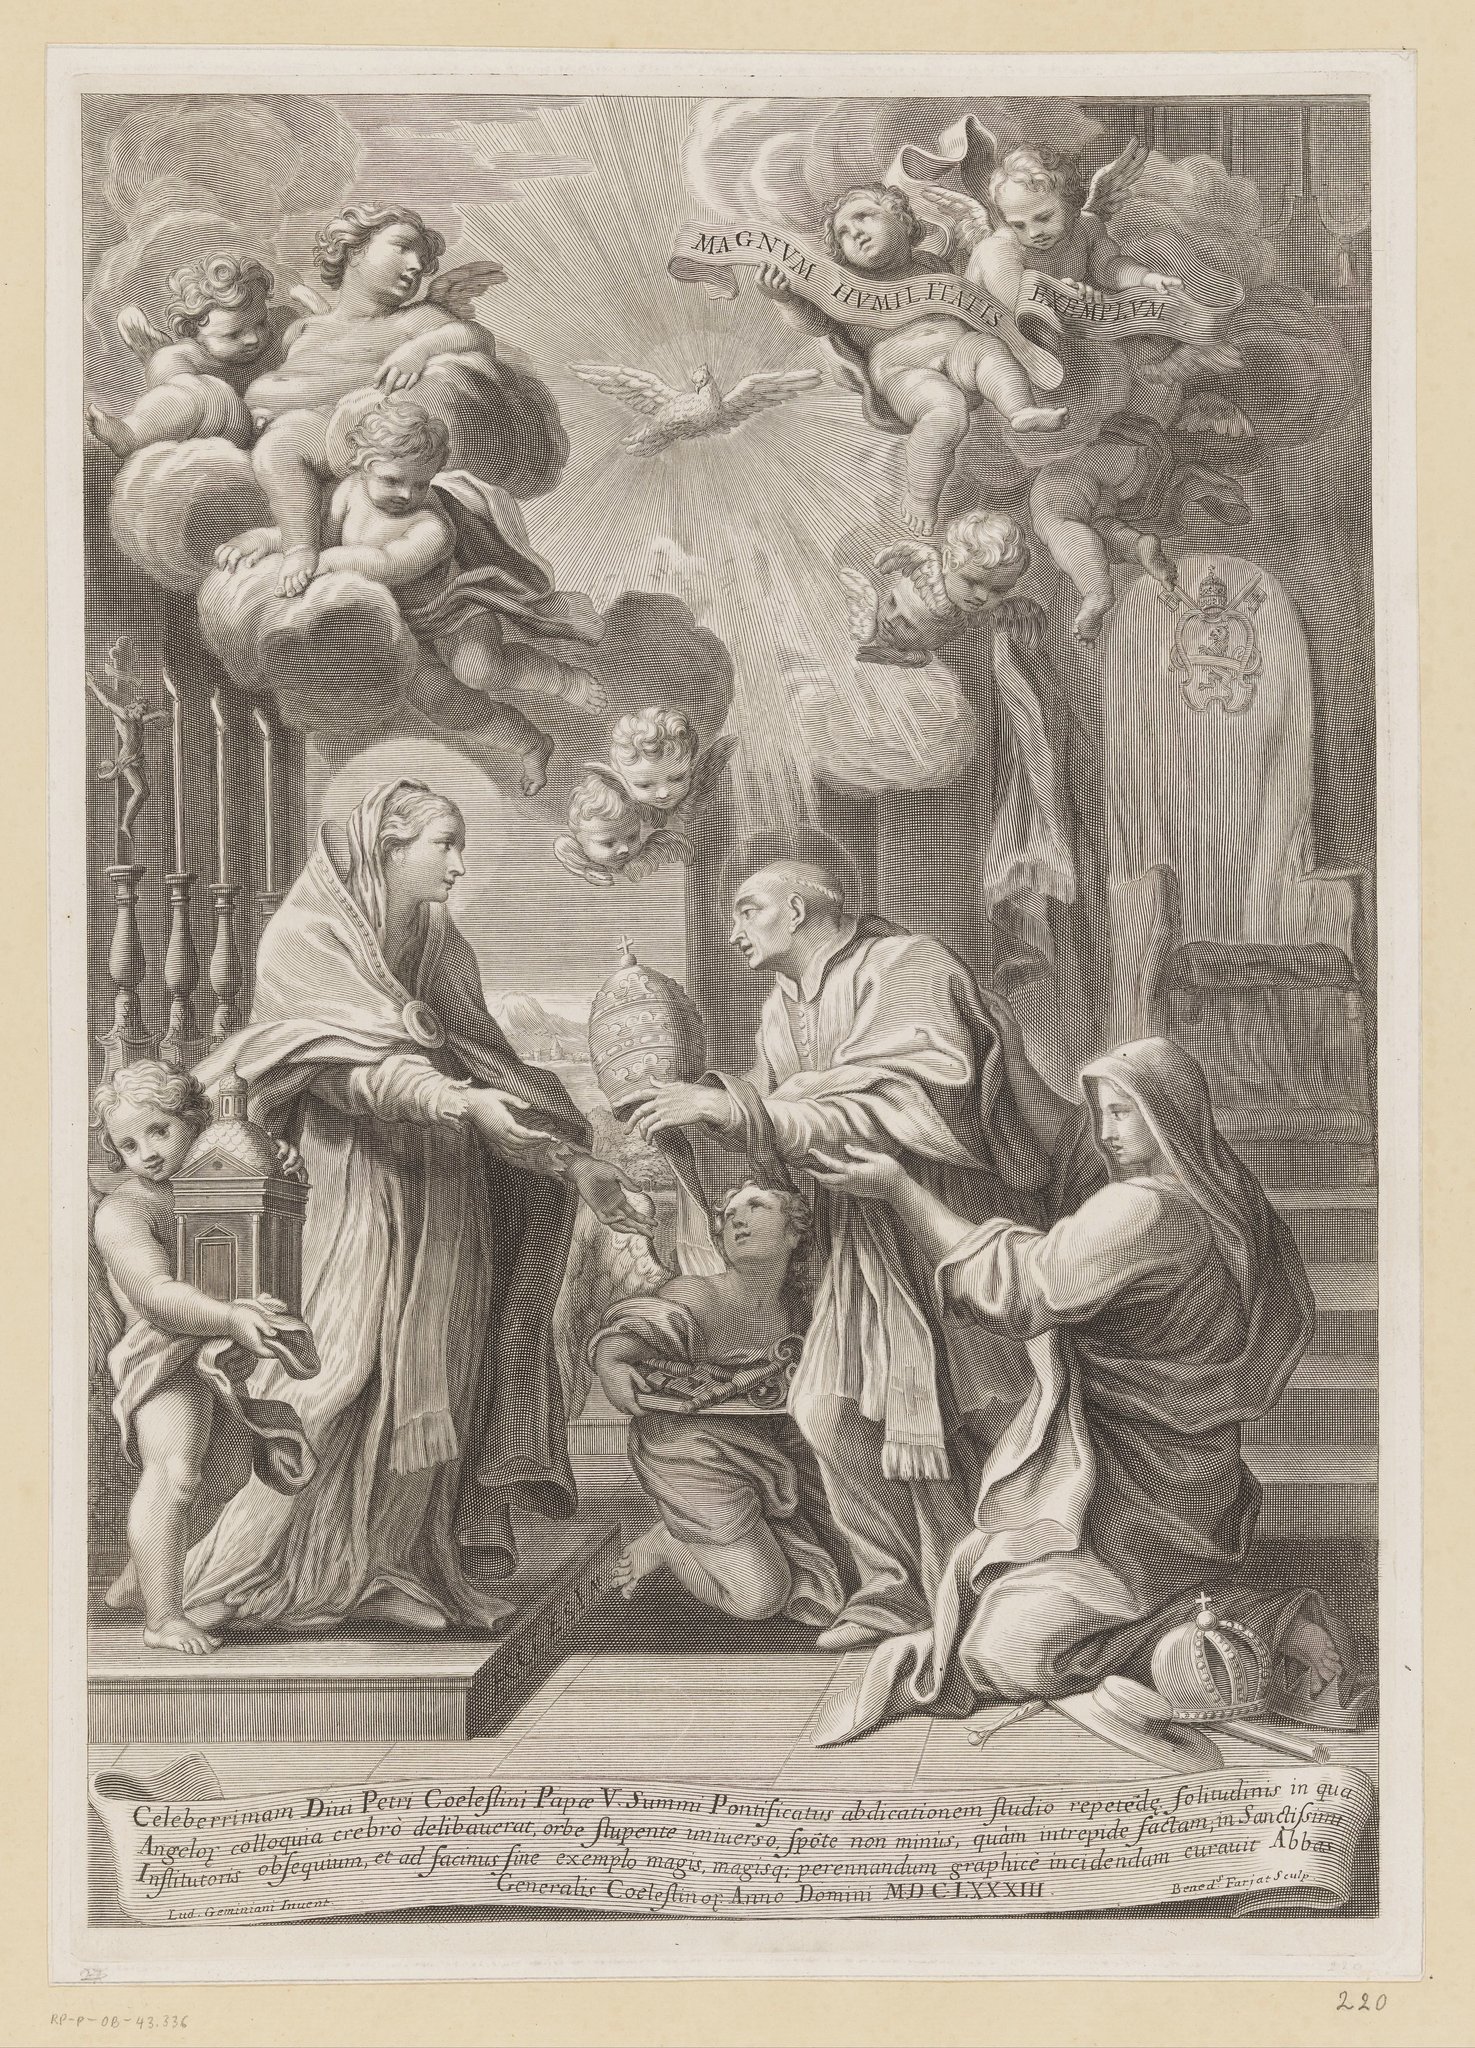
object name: print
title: Petrus overhandigt de pauselijke kroon aan Maria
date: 1683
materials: paper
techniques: engraving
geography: france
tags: specific aspects ~ st. peter (+ mary)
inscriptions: collector's mark: Lugt 240